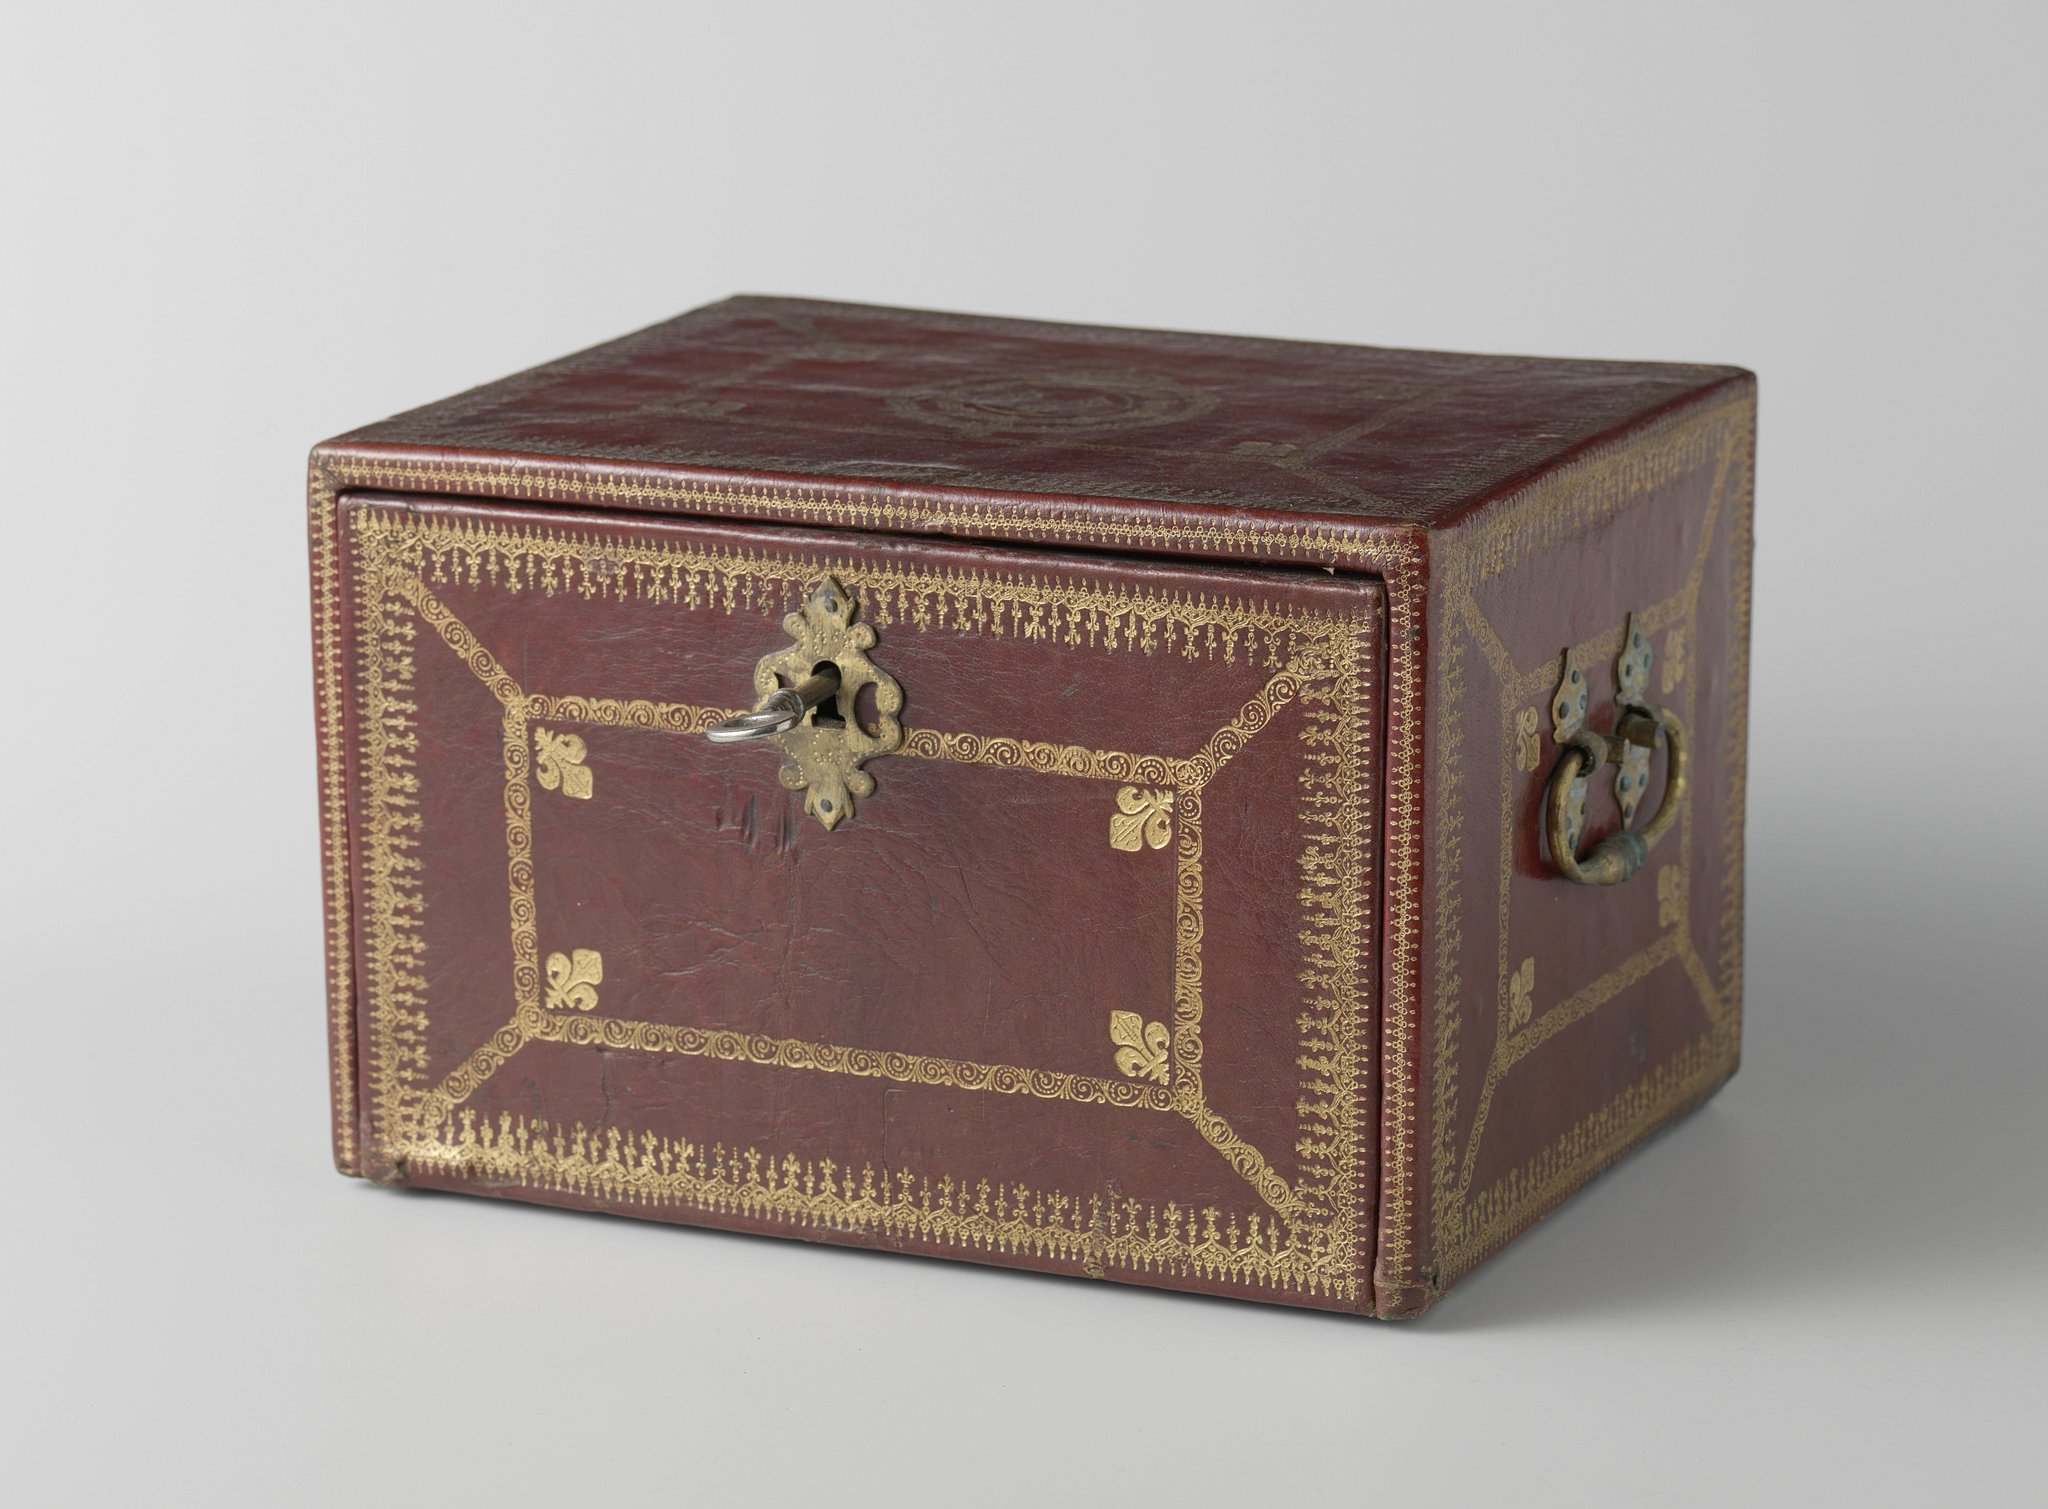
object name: medal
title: Casket with portrait medallions of the French kings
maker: Anonymous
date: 1715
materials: leather, wood, silver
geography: paris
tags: fleur-de-lis ~ ornament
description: Kist, vierkant, met rood geperst en gedeeltelijk verguld leder overtrokken. Daarin 7 laden met vijfenzestig penningen met de portretten van de Franse koningen. In de onderste lade een papieren document. Bij de kist hoort een sleutel.